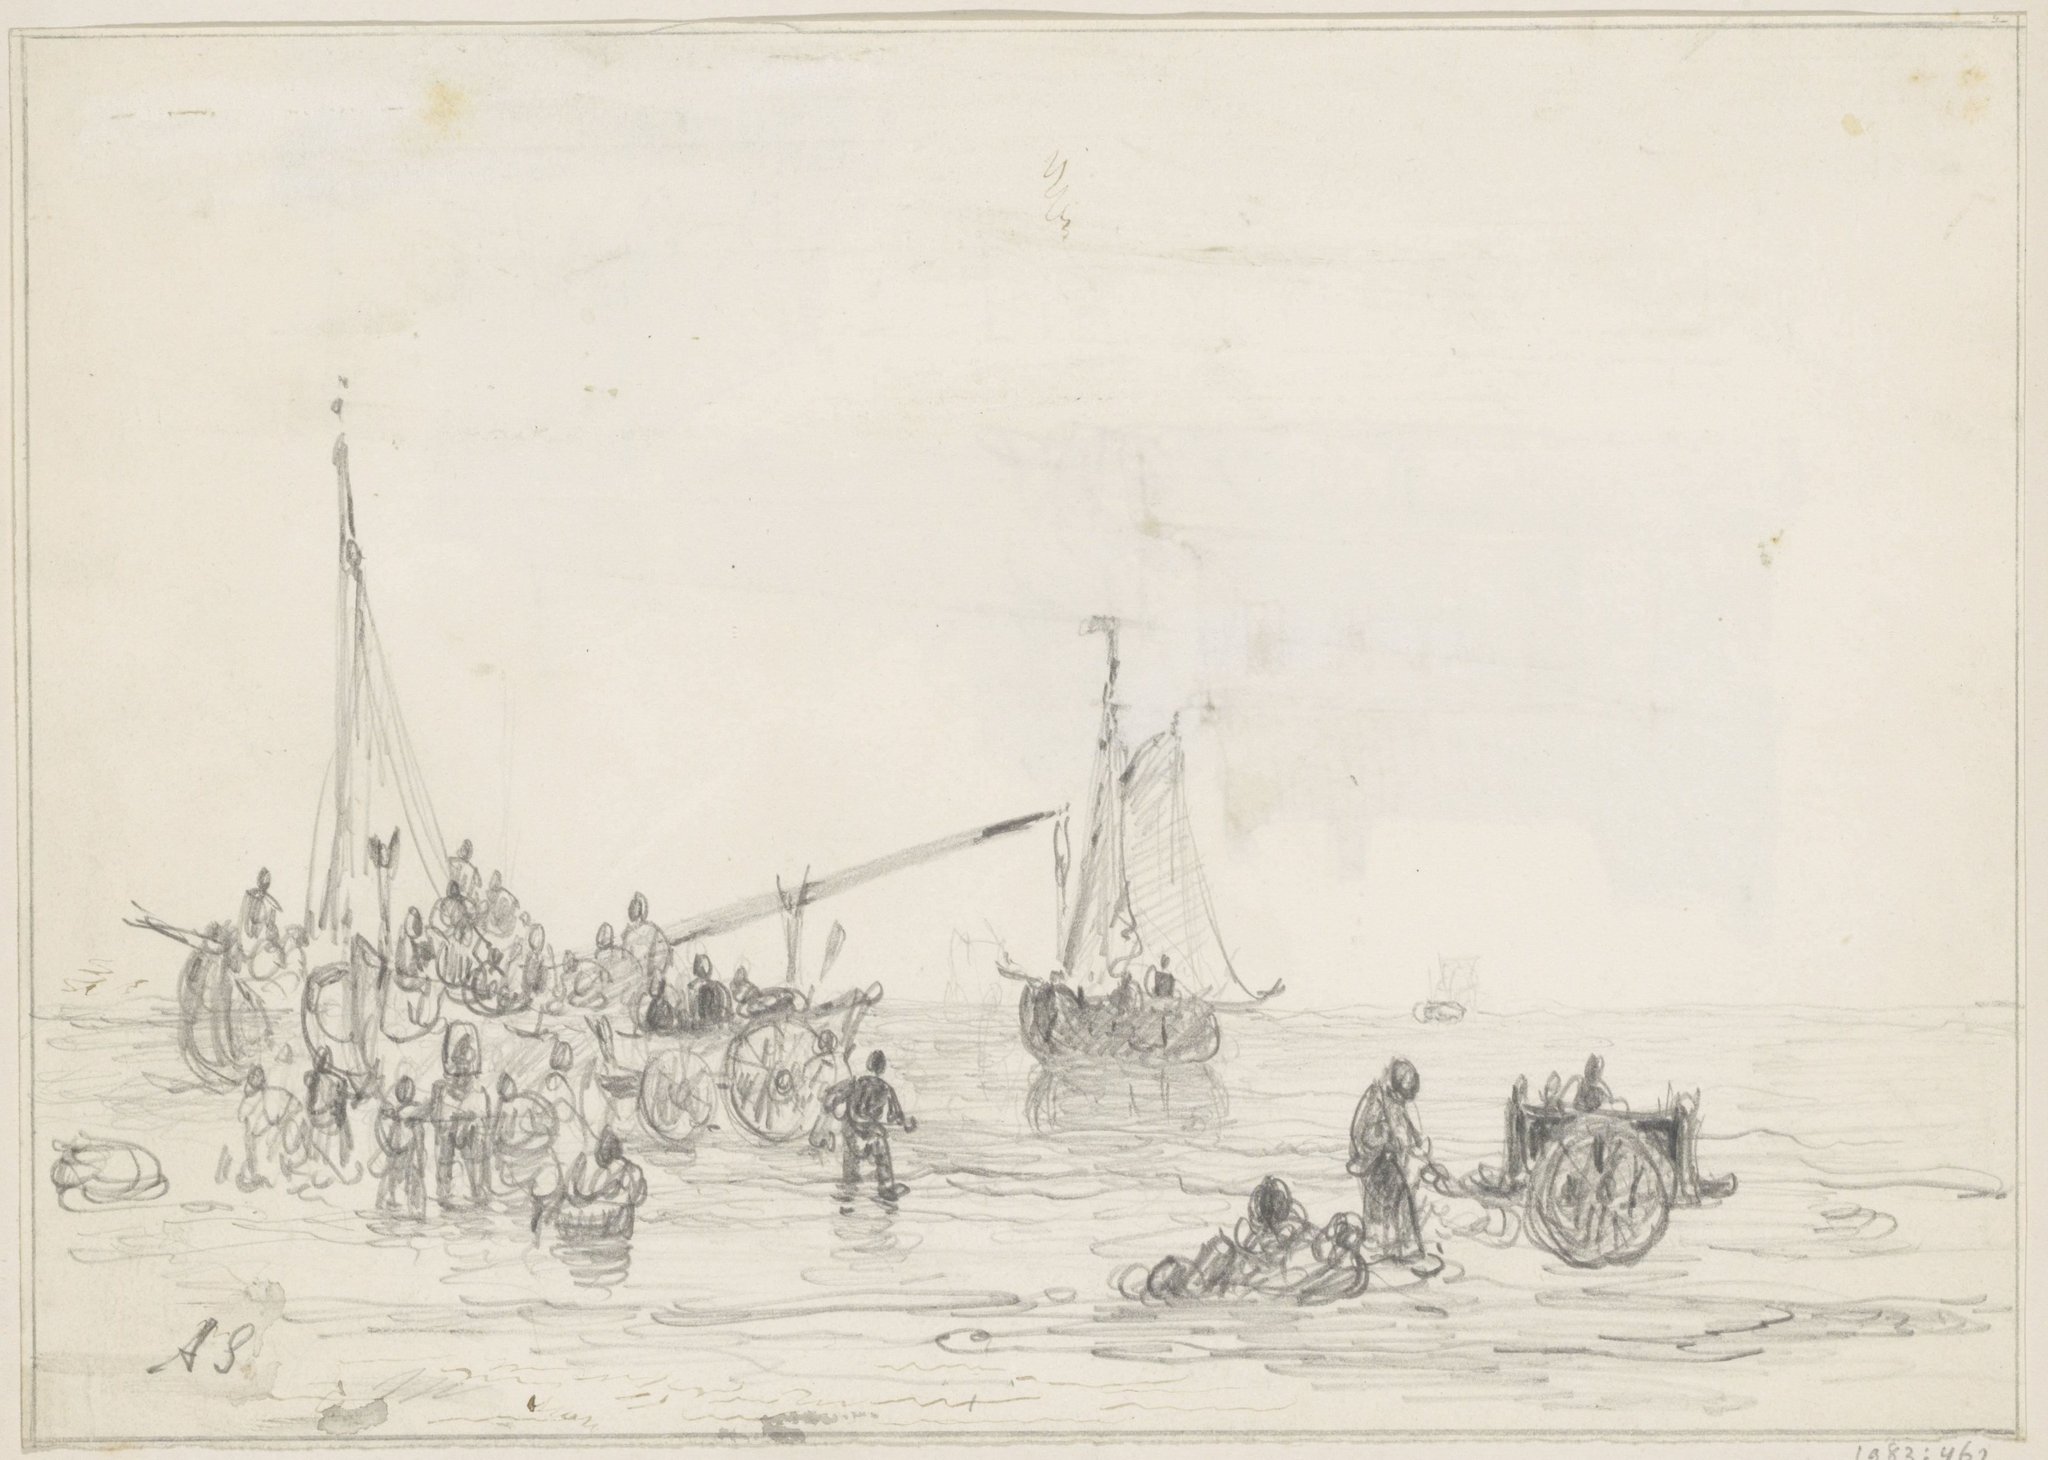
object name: drawing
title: Strandgezicht met figuren bij een schip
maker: andreas schelfhout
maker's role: draughtsman, painter, print maker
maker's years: 1787-1870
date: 1797-1870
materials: ink, paper, pencil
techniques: pen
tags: sailing-ship, sailing-boat, beach (+ landscape with figures, staffage)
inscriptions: signature: ‘AS’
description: Op een strand hebben figuren zich bij de vloedlijn verzameld rond een schip. Op de voorgrond een man met een kar. Recto van een tekening die deel uitmaakt van een album.